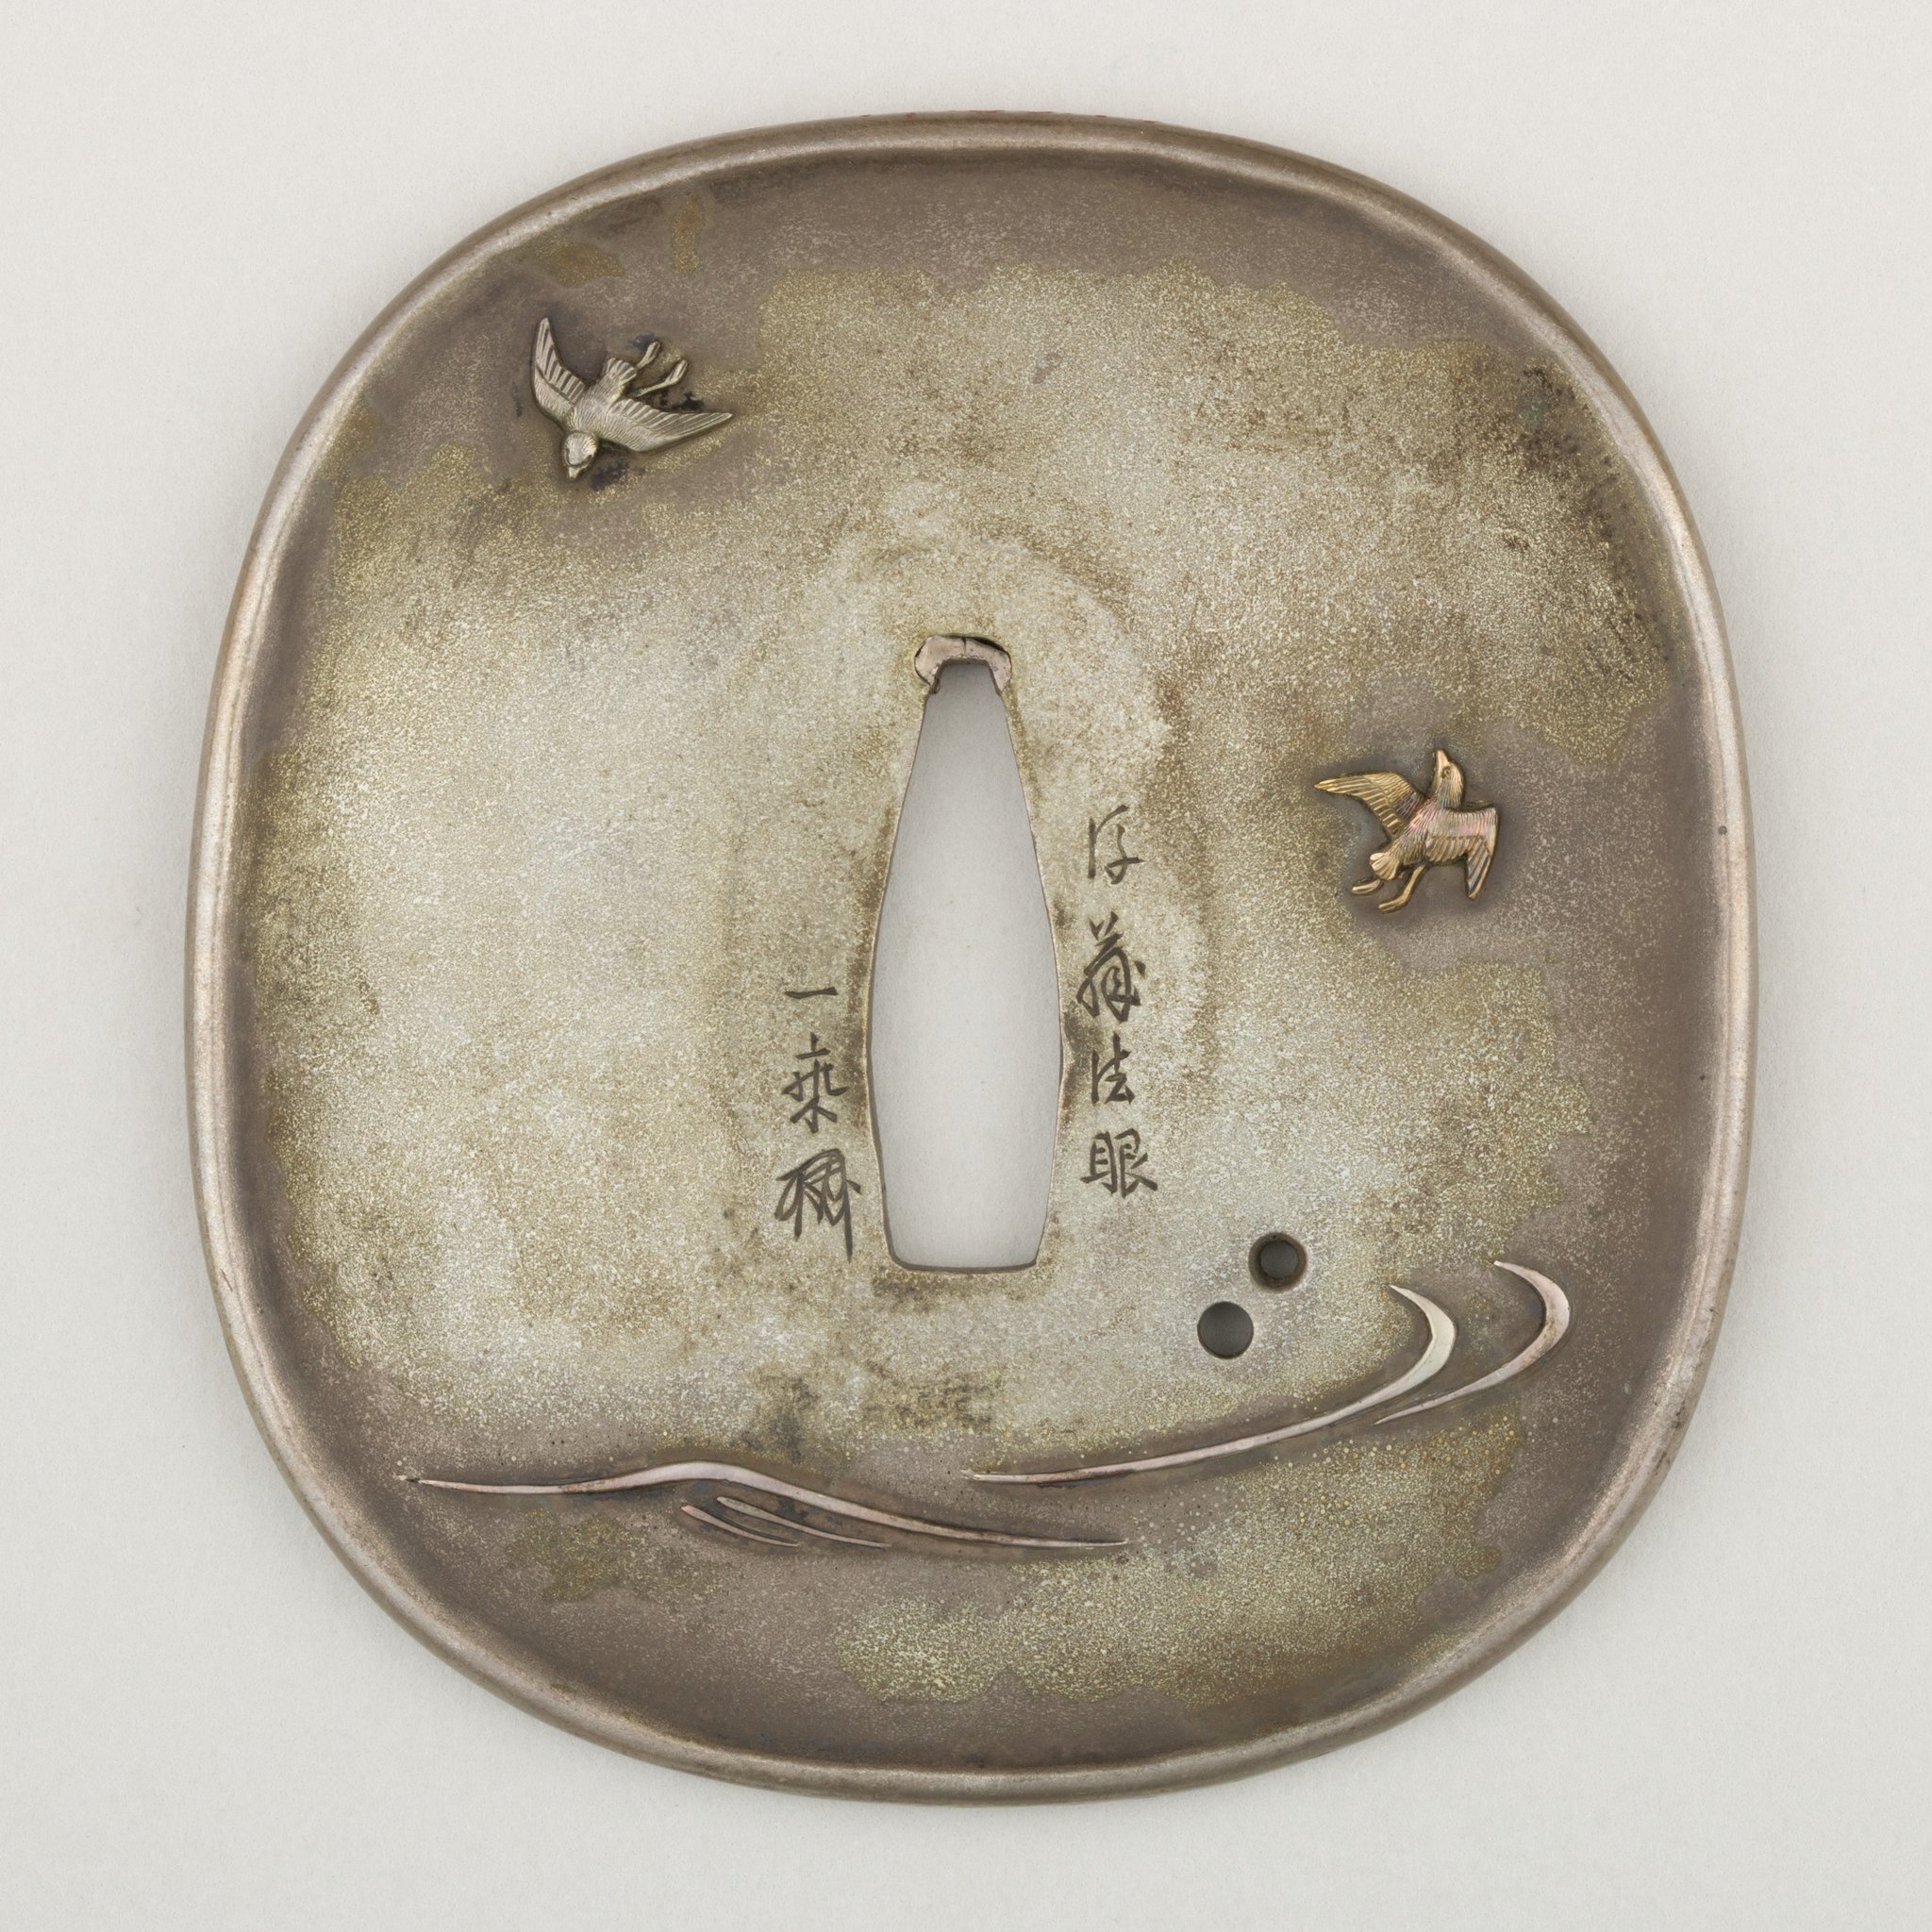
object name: sword guard tsuba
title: Sword Guard (Tsuba)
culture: japanese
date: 1801-1900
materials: copper, silver alloy, gold, silver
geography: japan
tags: birds